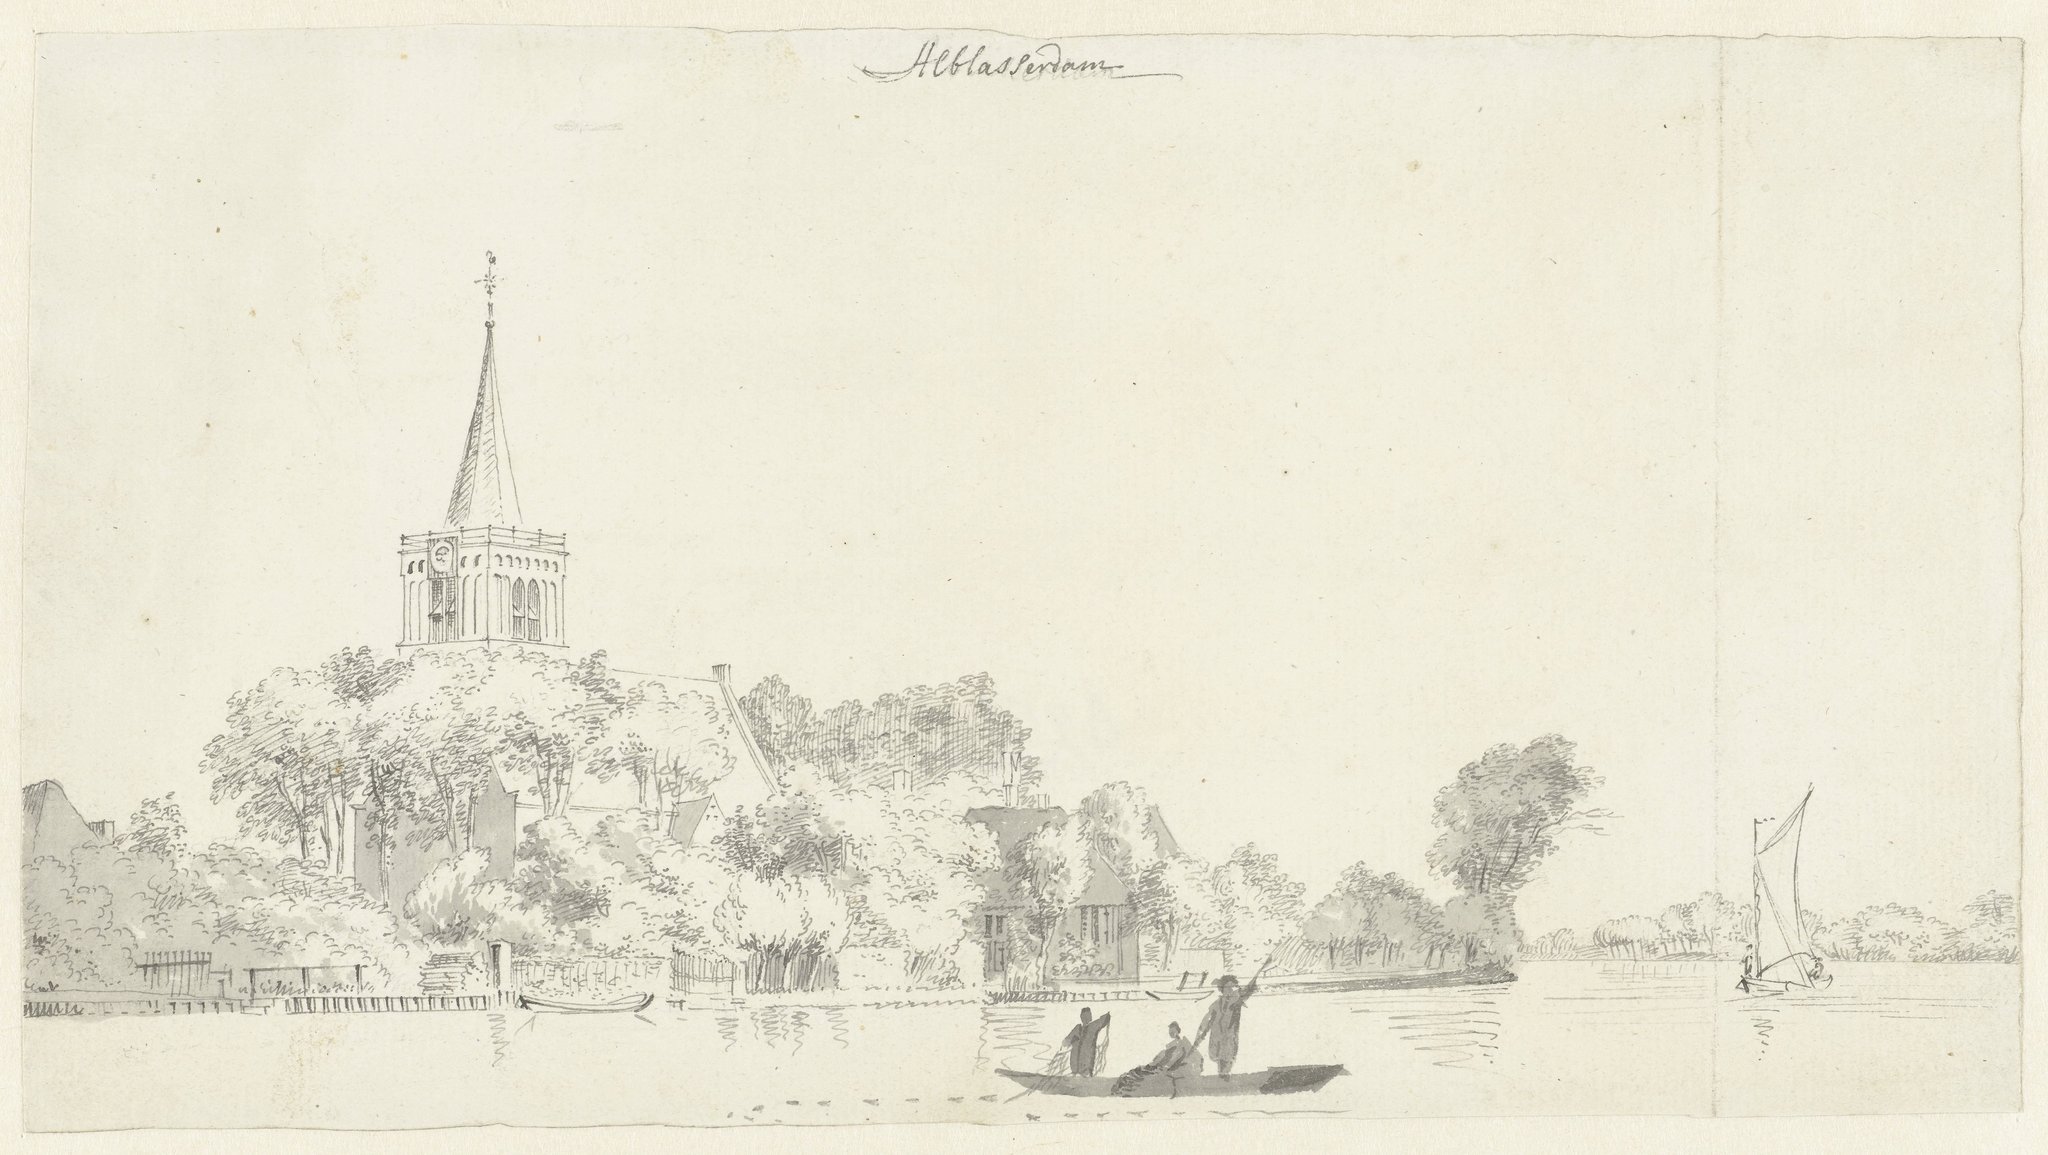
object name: drawing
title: Gezicht op Alblasserdam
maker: cornelis pronk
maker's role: draughtsman, painter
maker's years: 1691-1759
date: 1701-1759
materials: ink, paper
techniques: brush, pen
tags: church (exterior), founding a village